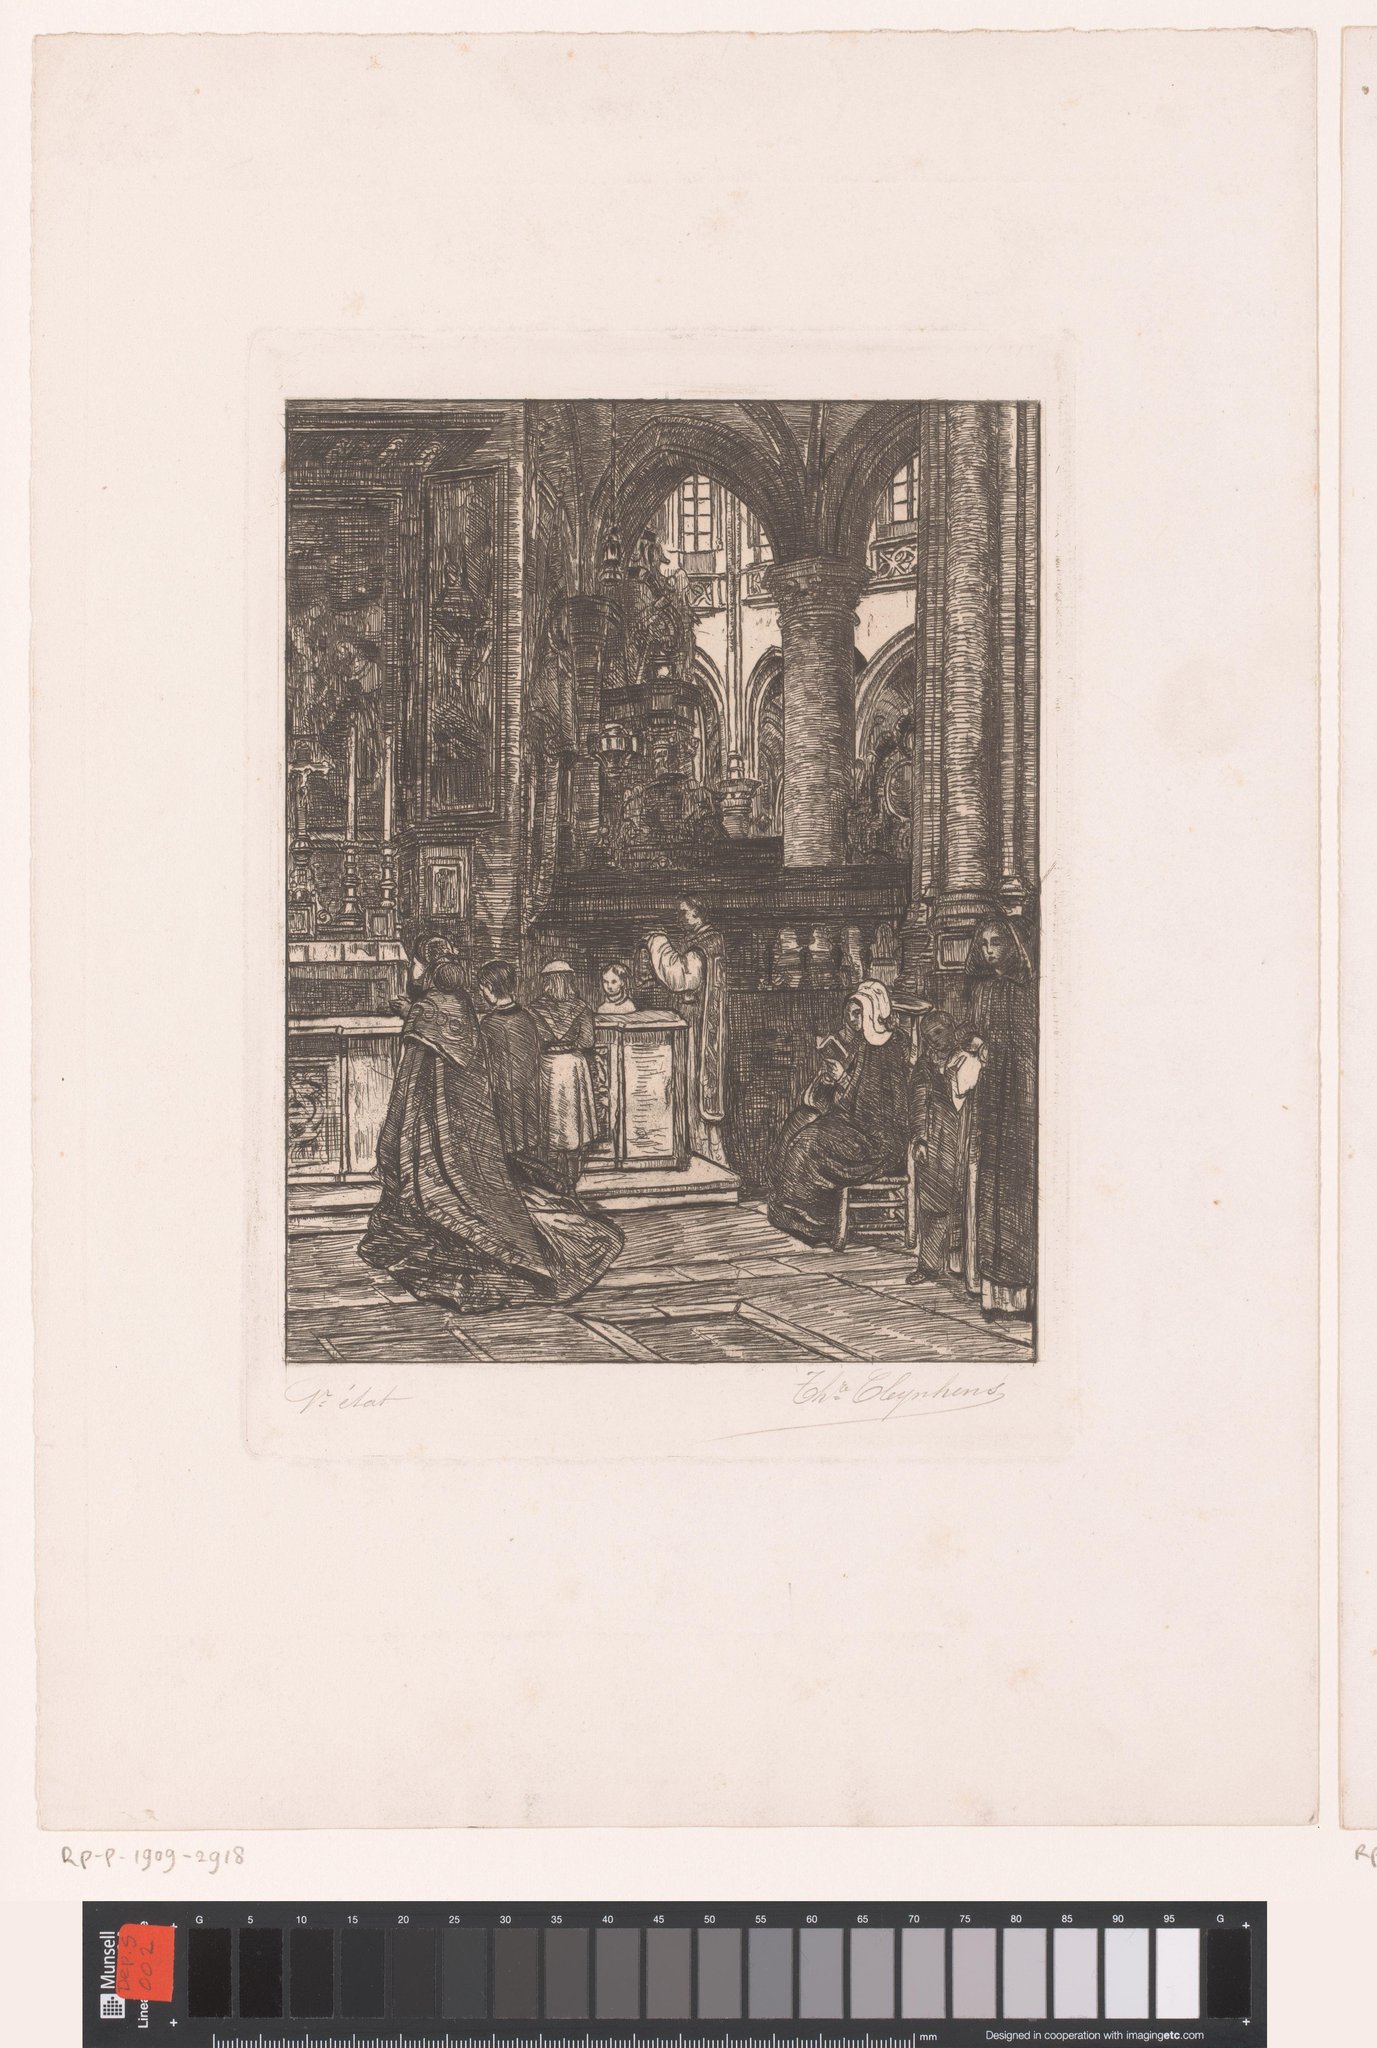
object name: print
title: Zijkapel van de Sint-Jacobskerk met figuren bij het altaar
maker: théodore joseph cleynhens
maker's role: print maker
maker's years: 1841-1916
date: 1851-1909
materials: paper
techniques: etching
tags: (public) prayer, interior of church, altar, antwerp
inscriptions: collector's mark: Lugt 2228, inscription: ‘Ve état’